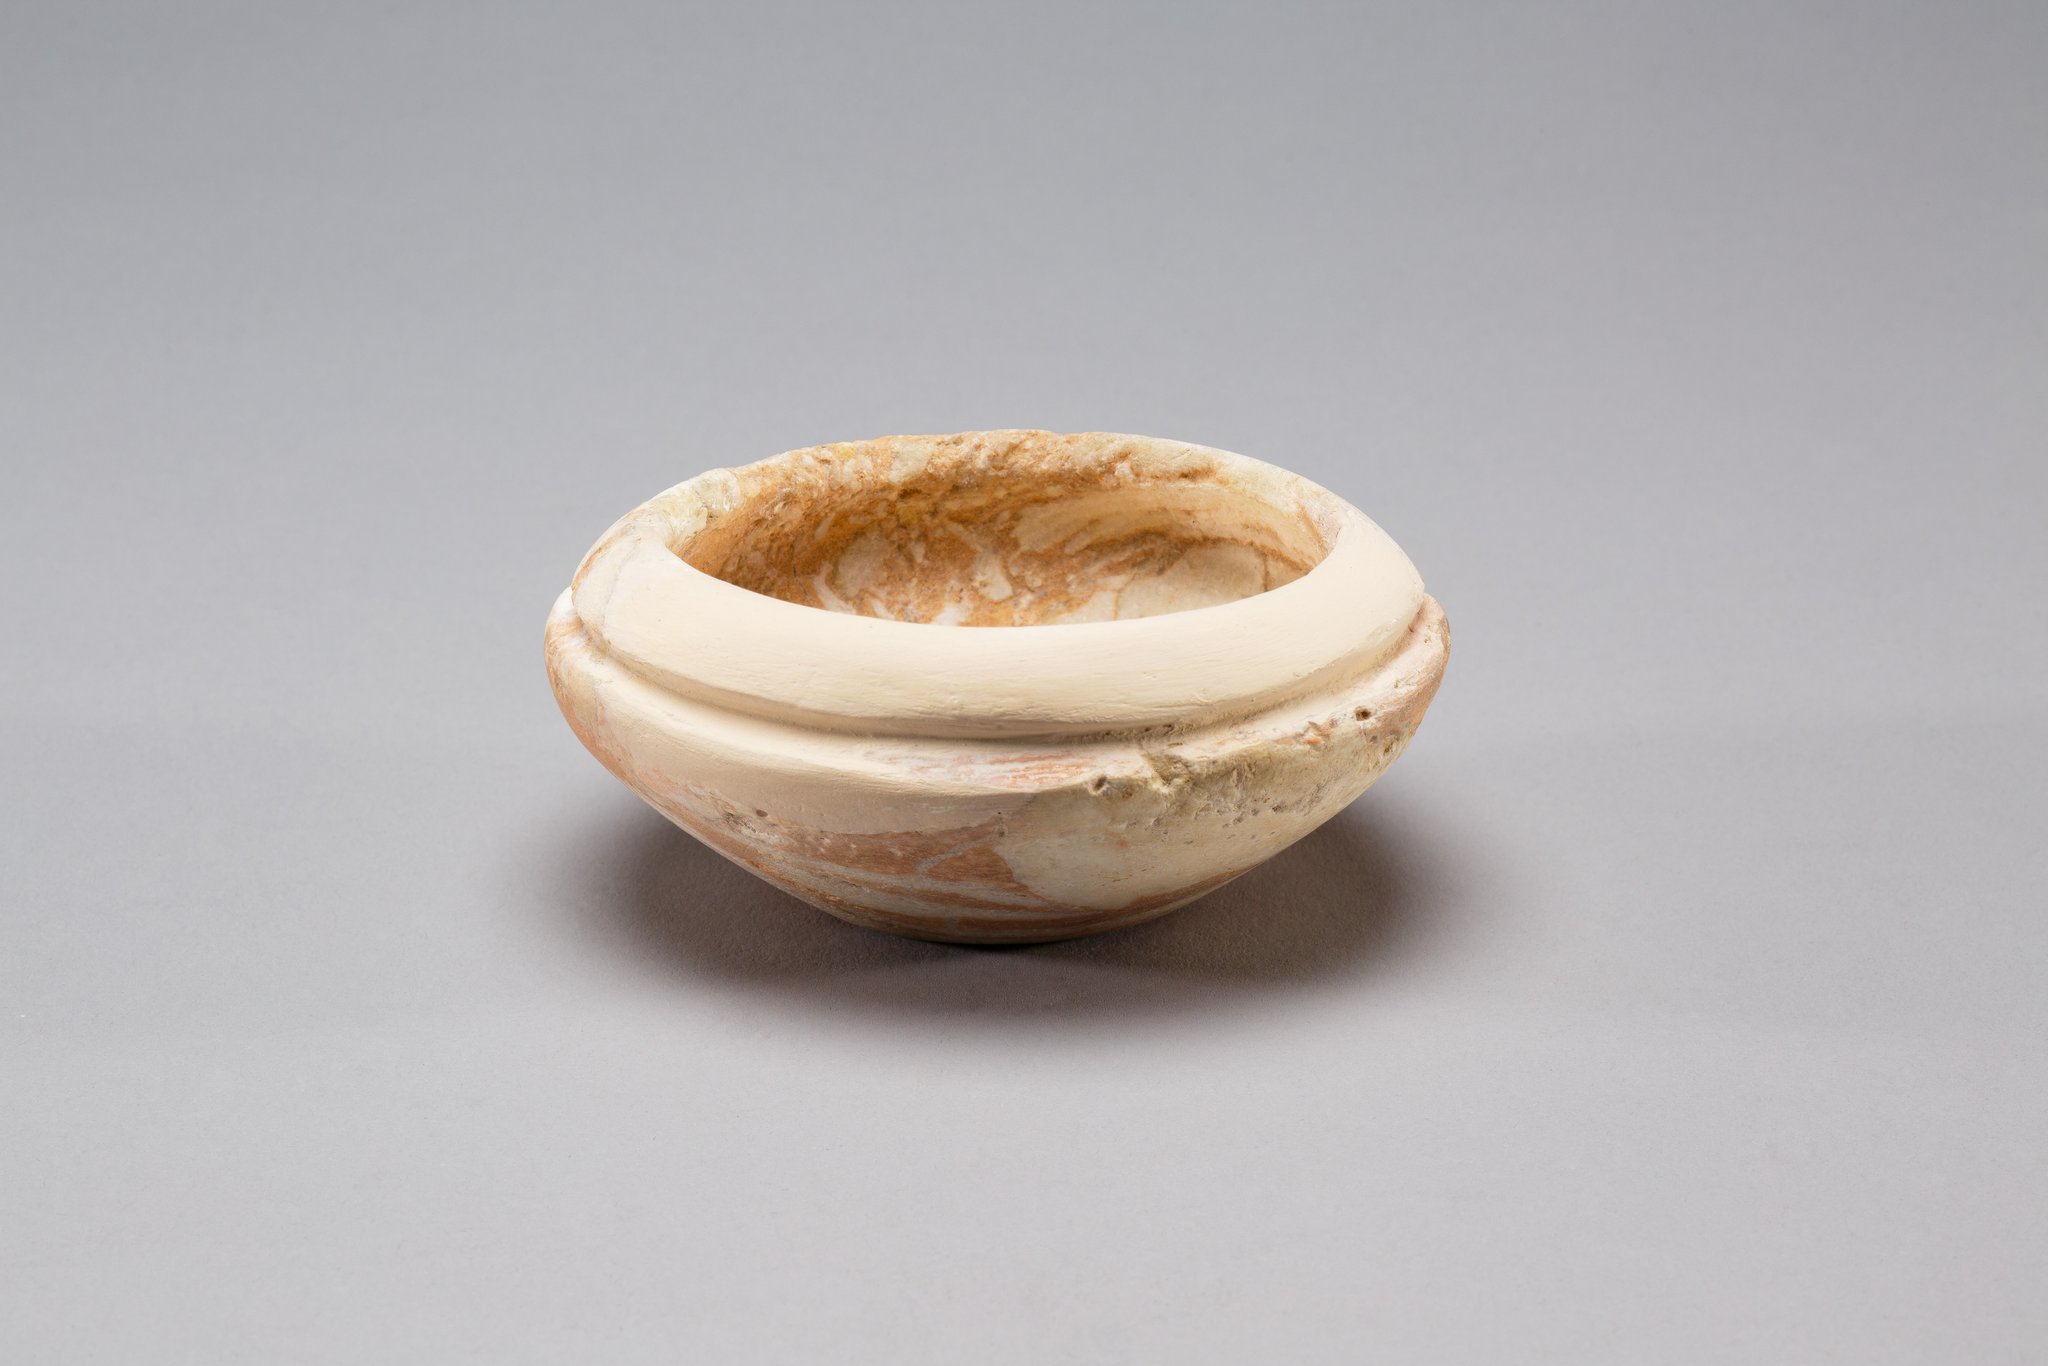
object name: bowl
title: Small rimmed bowl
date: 2750-2649 BCE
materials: limestone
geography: egypt